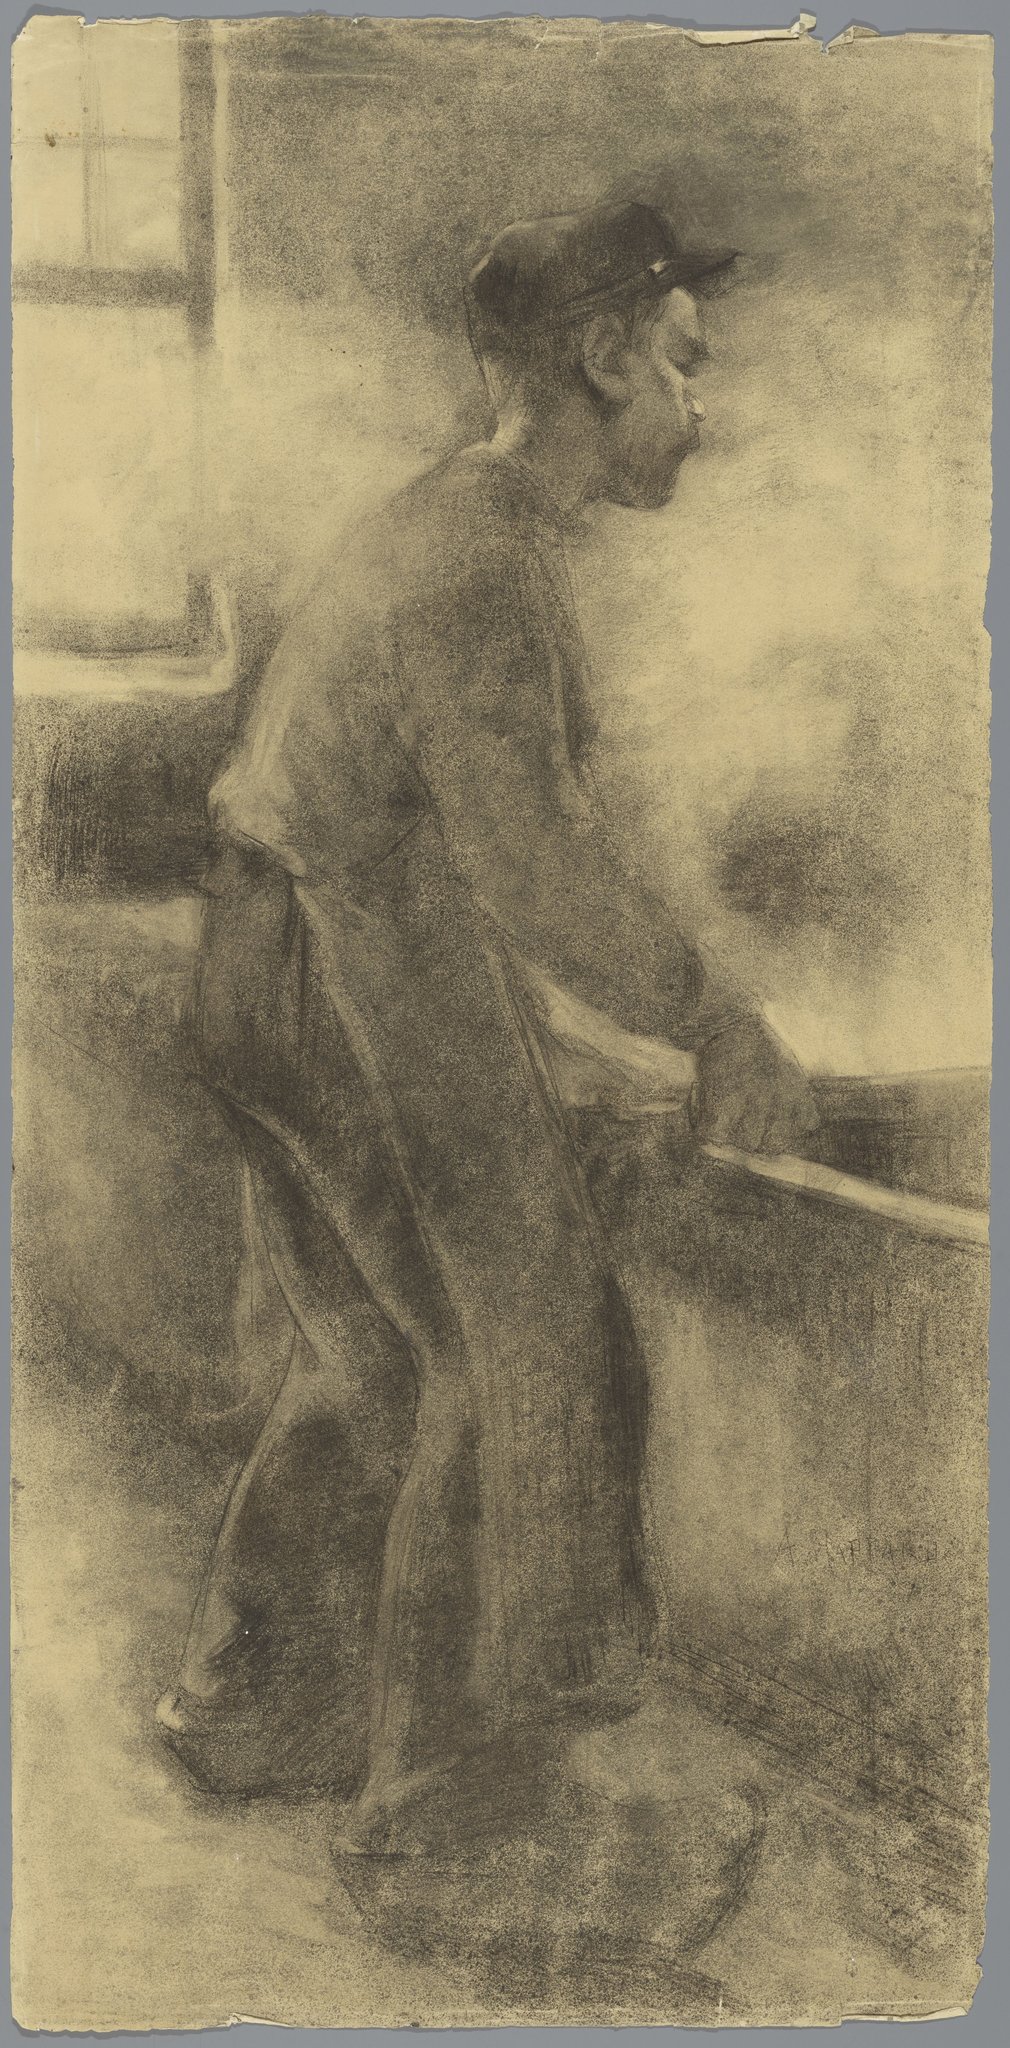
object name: drawing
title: Krabber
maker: anthon gerhard alexander van rappard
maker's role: draughtsman, print maker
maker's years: 1858-1892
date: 1868-1892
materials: charcoal, paper